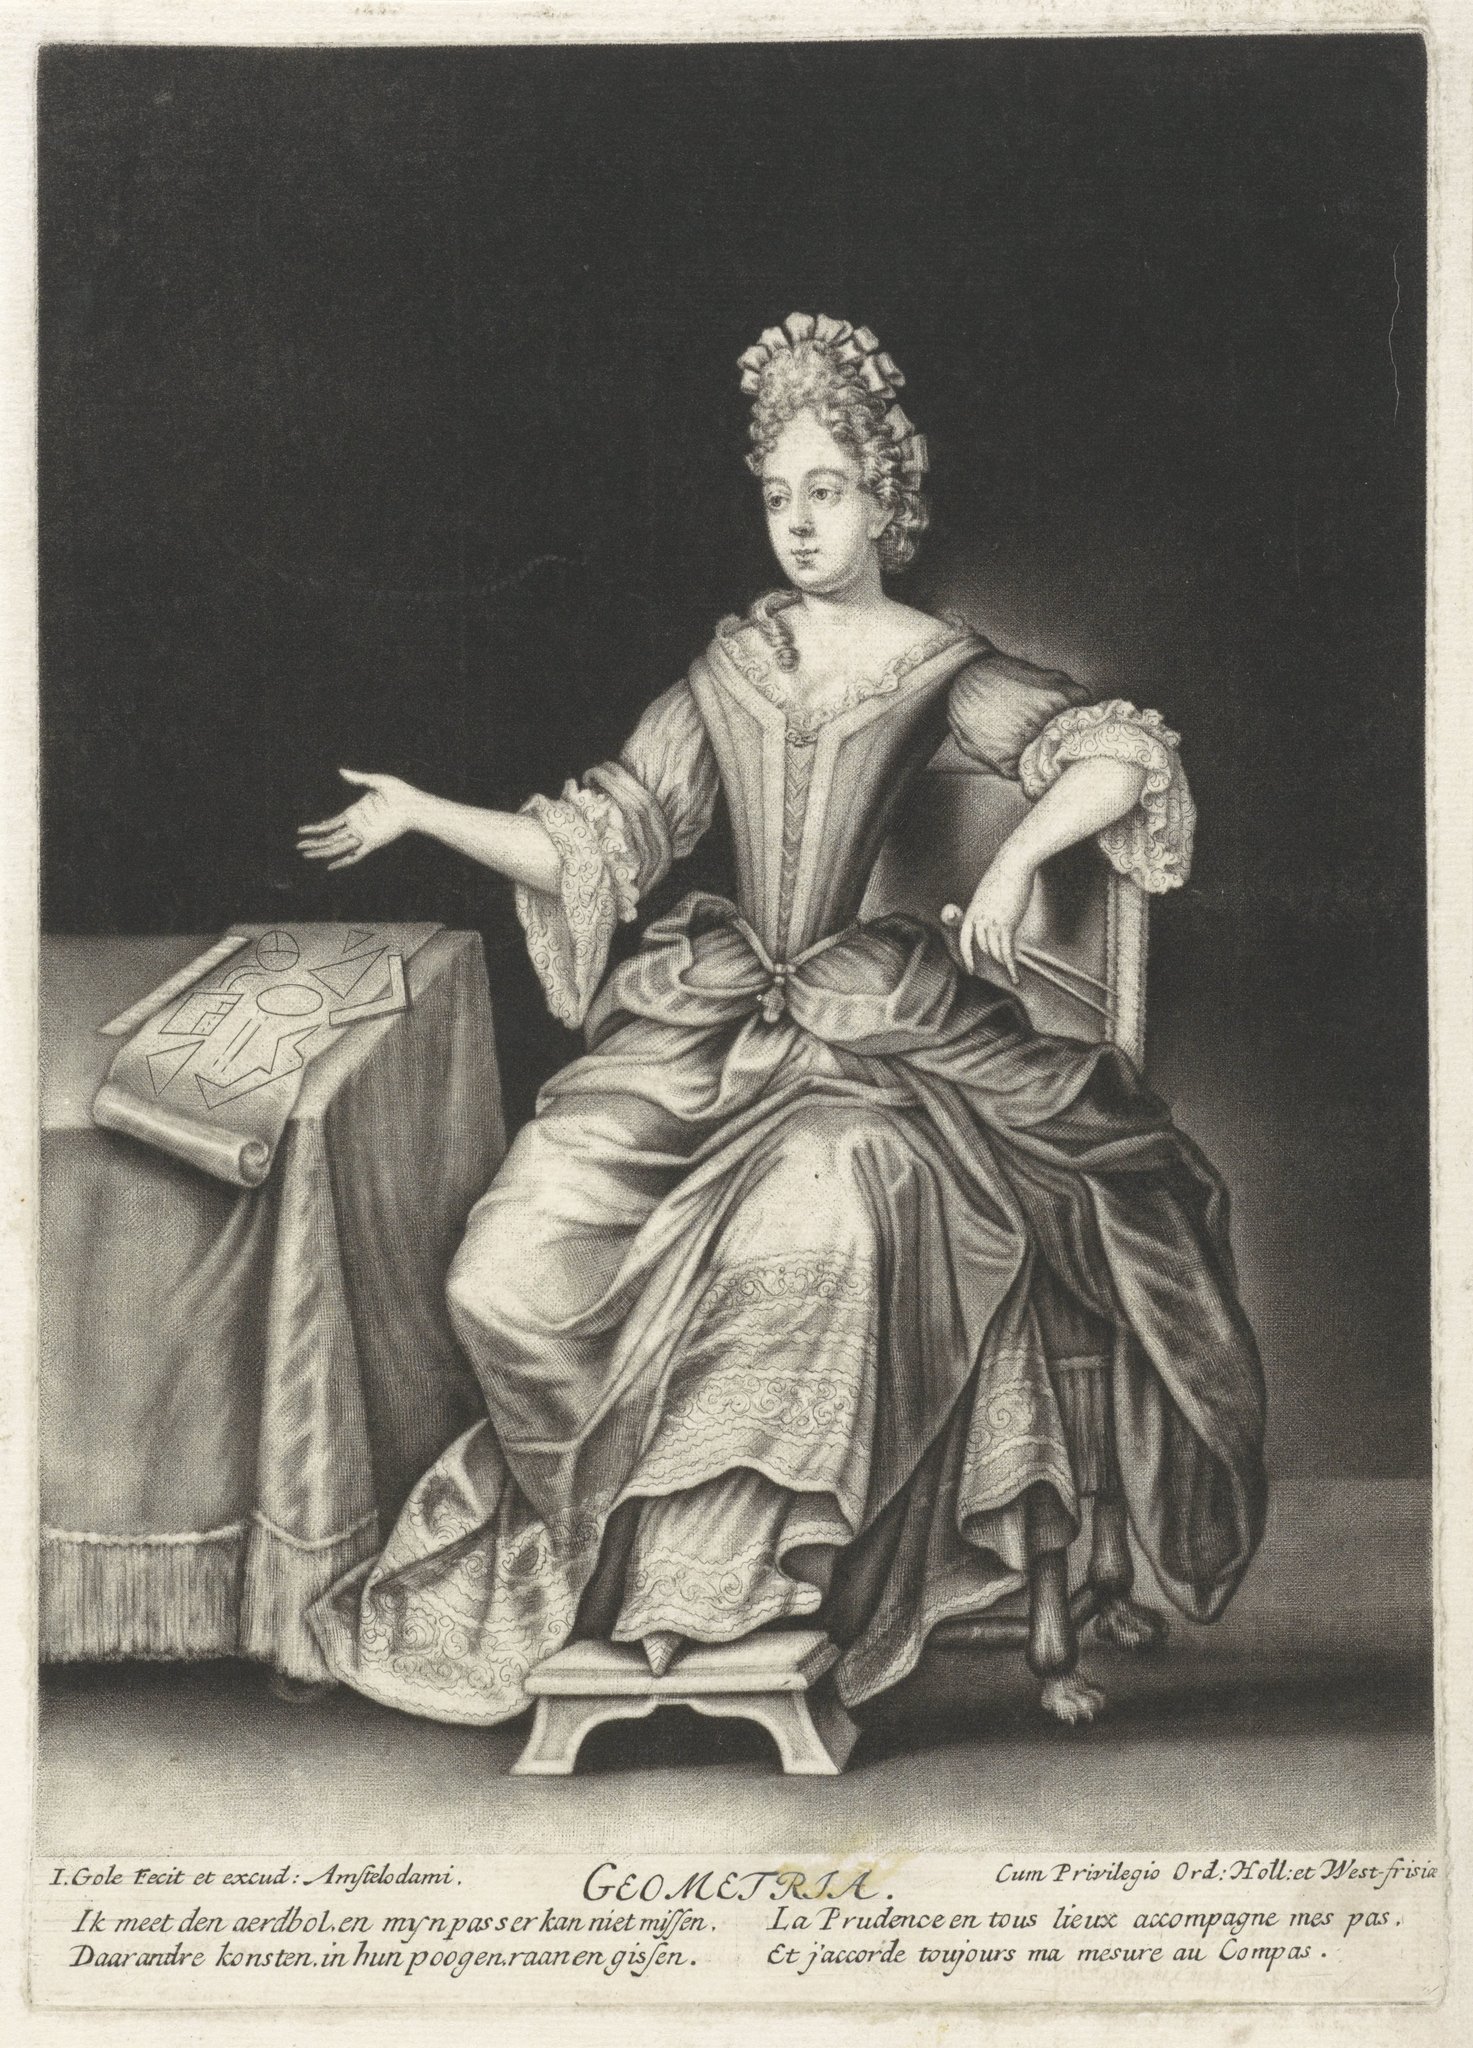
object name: print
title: Geometria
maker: jacob gole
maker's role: print maker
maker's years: 1660-1724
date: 1670-1724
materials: paper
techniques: engraving, etching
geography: amsterdam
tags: 'geometria' (~ quadrivium); 'geometria' (ripa), compasses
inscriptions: collector's mark: Lugt 2228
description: De personificatie van Geometria (Meetkunde) zit aan een tafel waarop een blad met geometrische figuren. Ze heeft een passer in de hand. De prent maakt deel uit van een zevendelige serie over de zeven vrije kunsten.